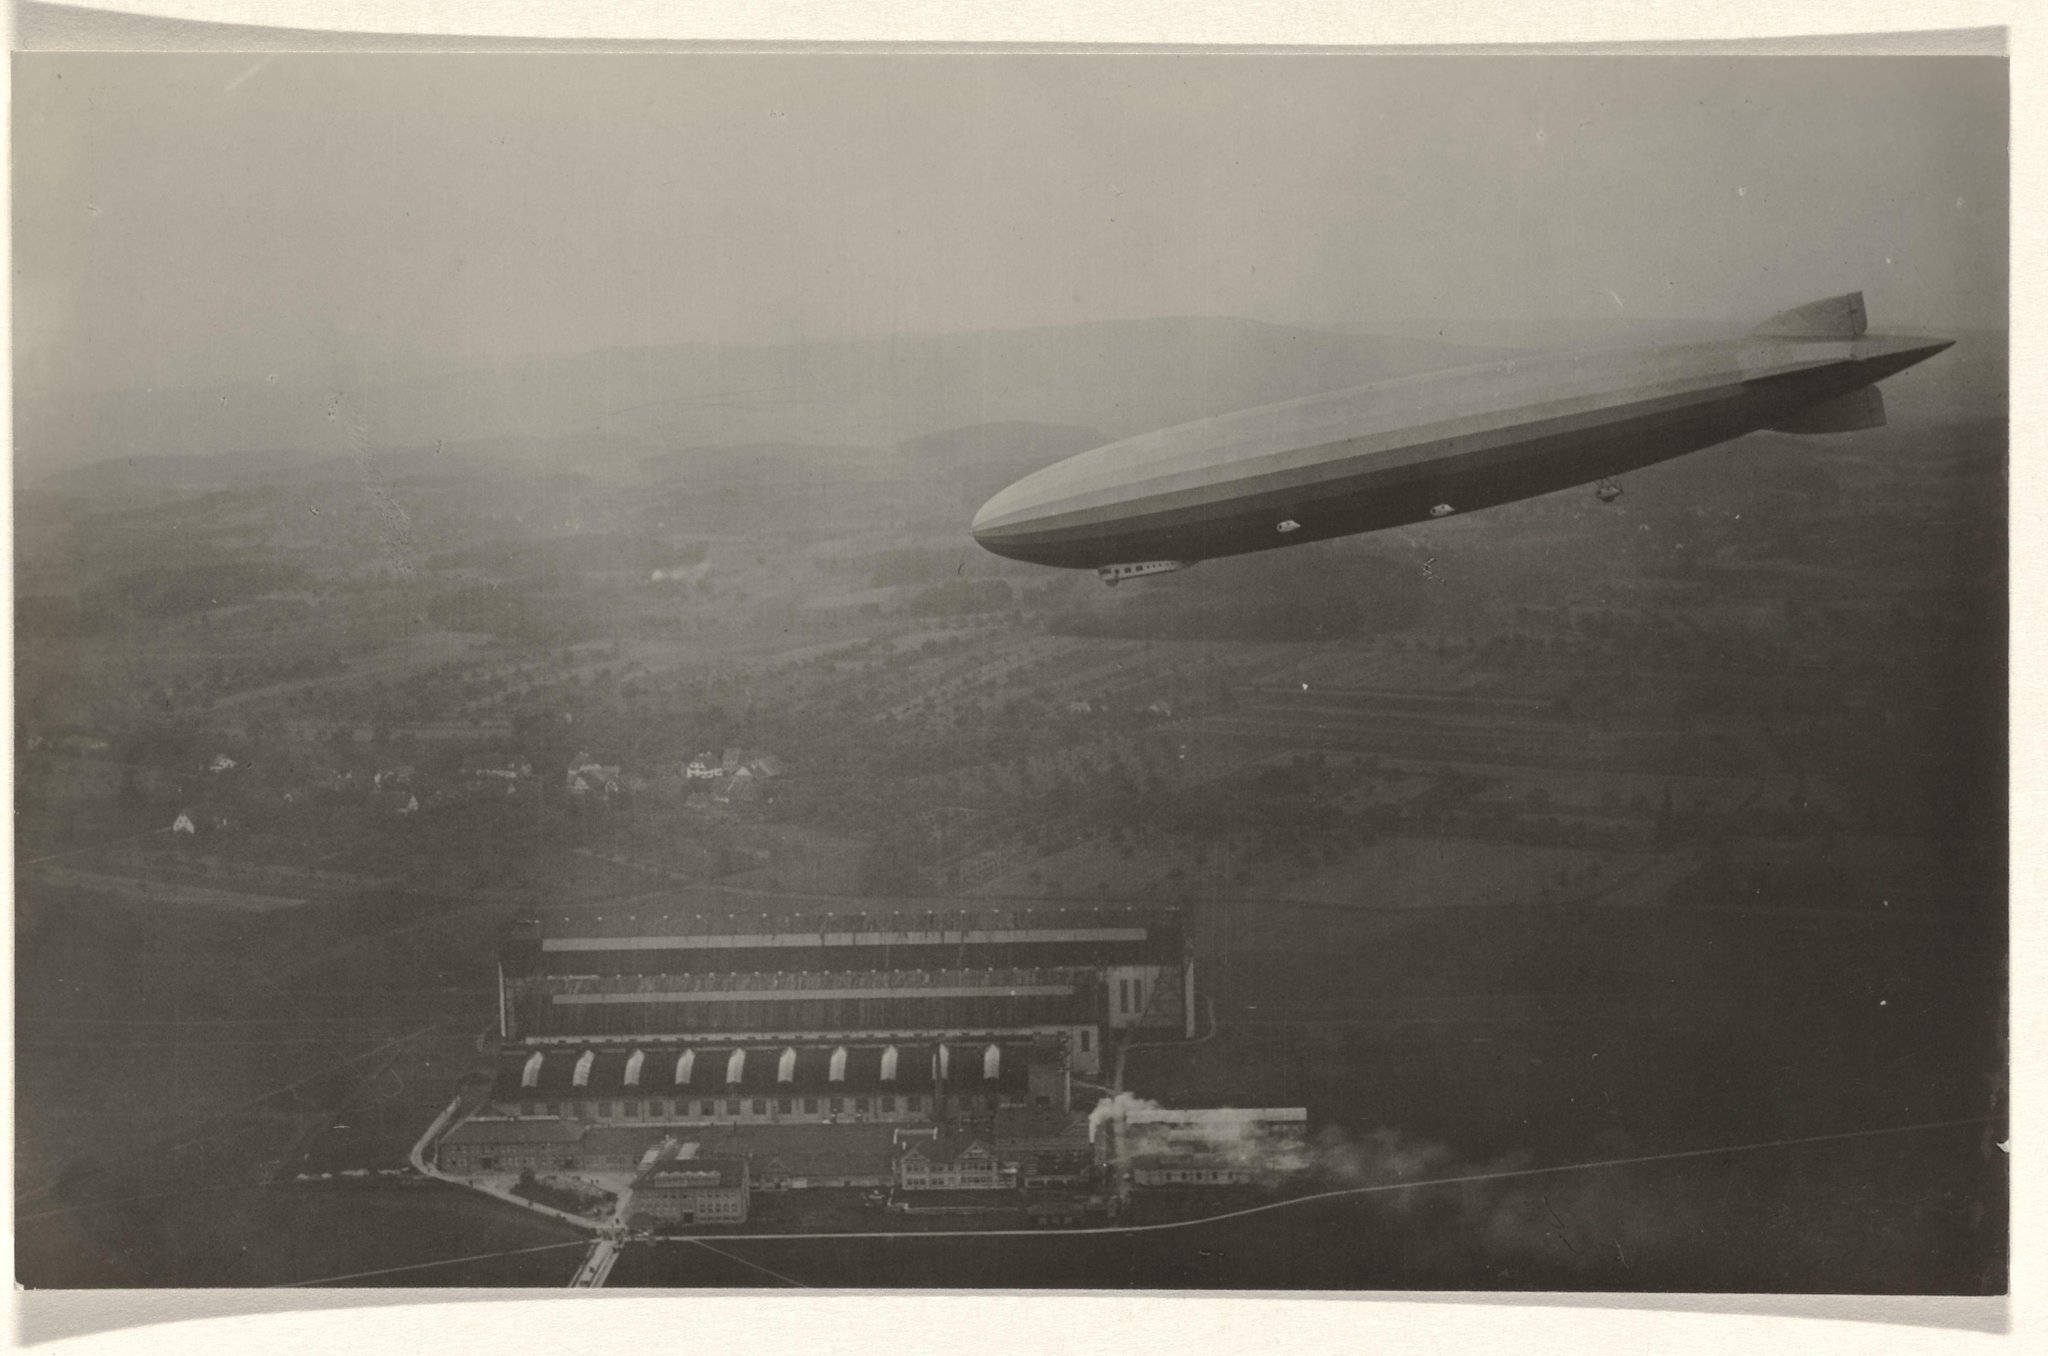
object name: photograph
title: De Amerika-zeppelin ZR 3 bij een hangar in Friedrichshafen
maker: Anonymous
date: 1924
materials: photographic support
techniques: gelatin silver print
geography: friedrichshafen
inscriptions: inscription: ‘AMERIKA-ZEPPELIN Z R III über seiner Halle in Friedrichshafen. (aufgenommen von Prof. Maerker, Konstanz)’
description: Een zeppelin in de lucht met een hangar op de grond en gebouwen op de achtergrond